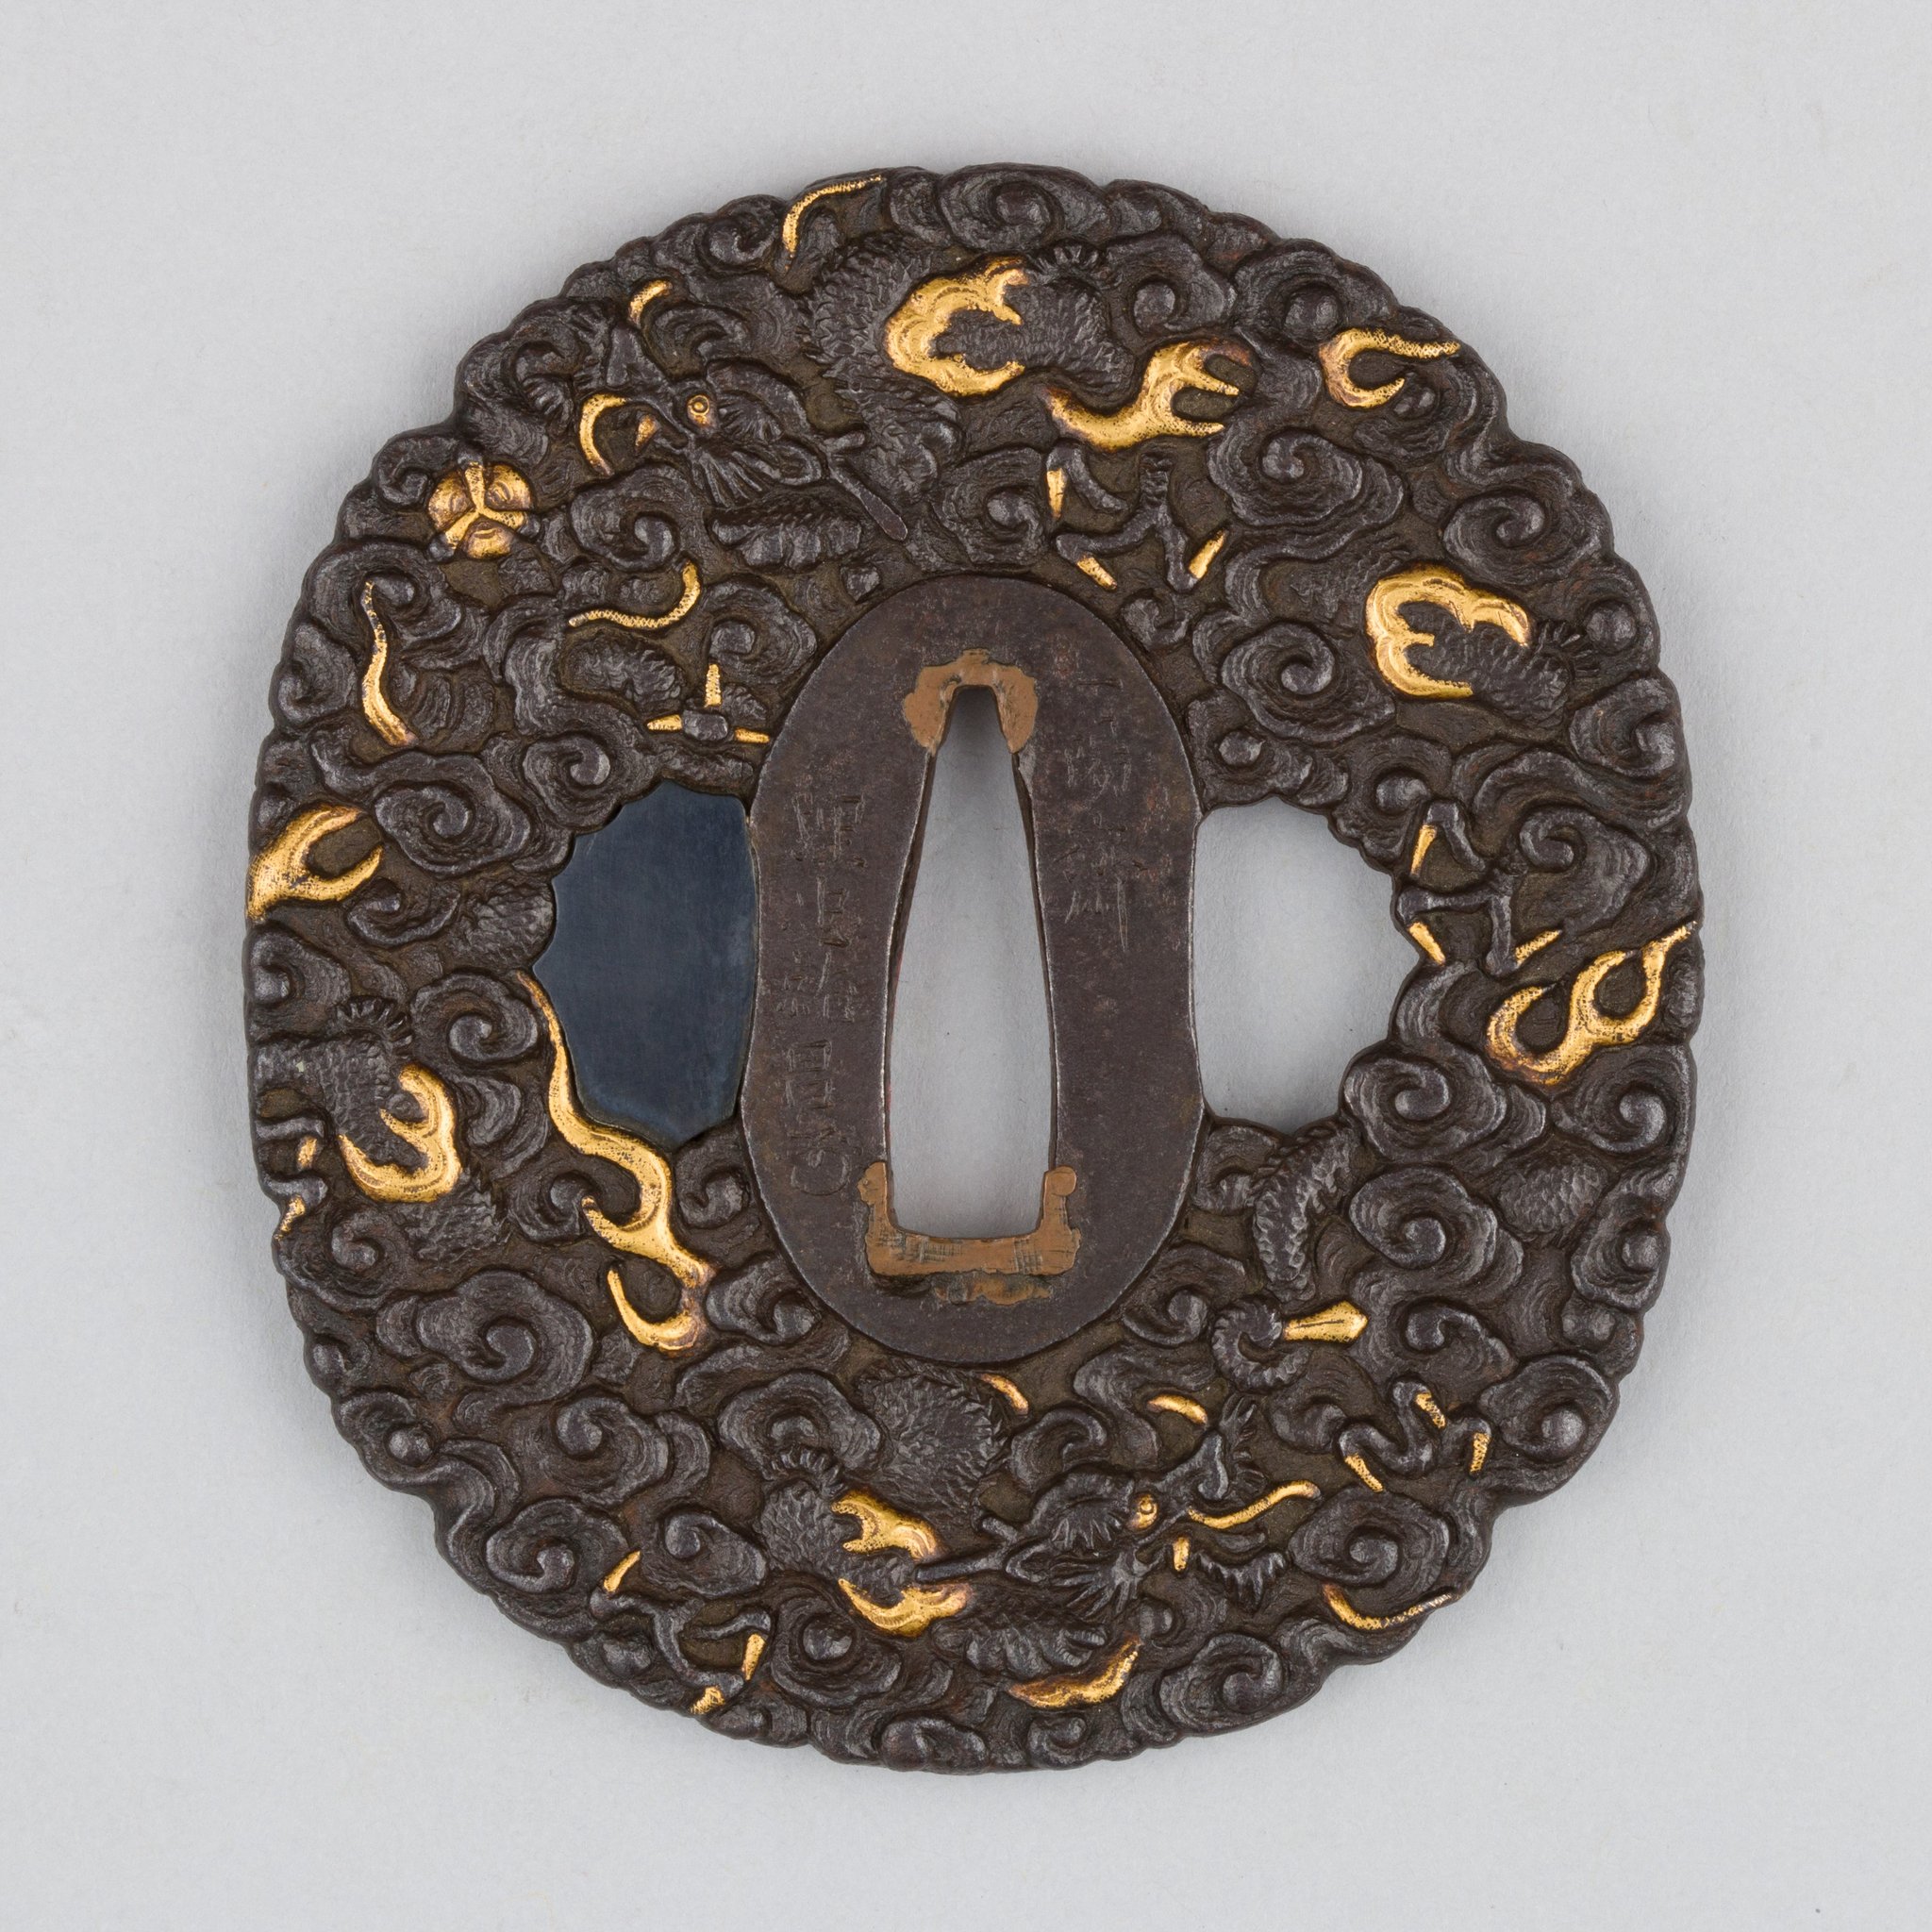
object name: sword guard tsuba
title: Sword Guard (Tsuba)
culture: japanese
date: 1701-1800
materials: copper, gold alloy, gold, iron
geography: japan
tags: dragons